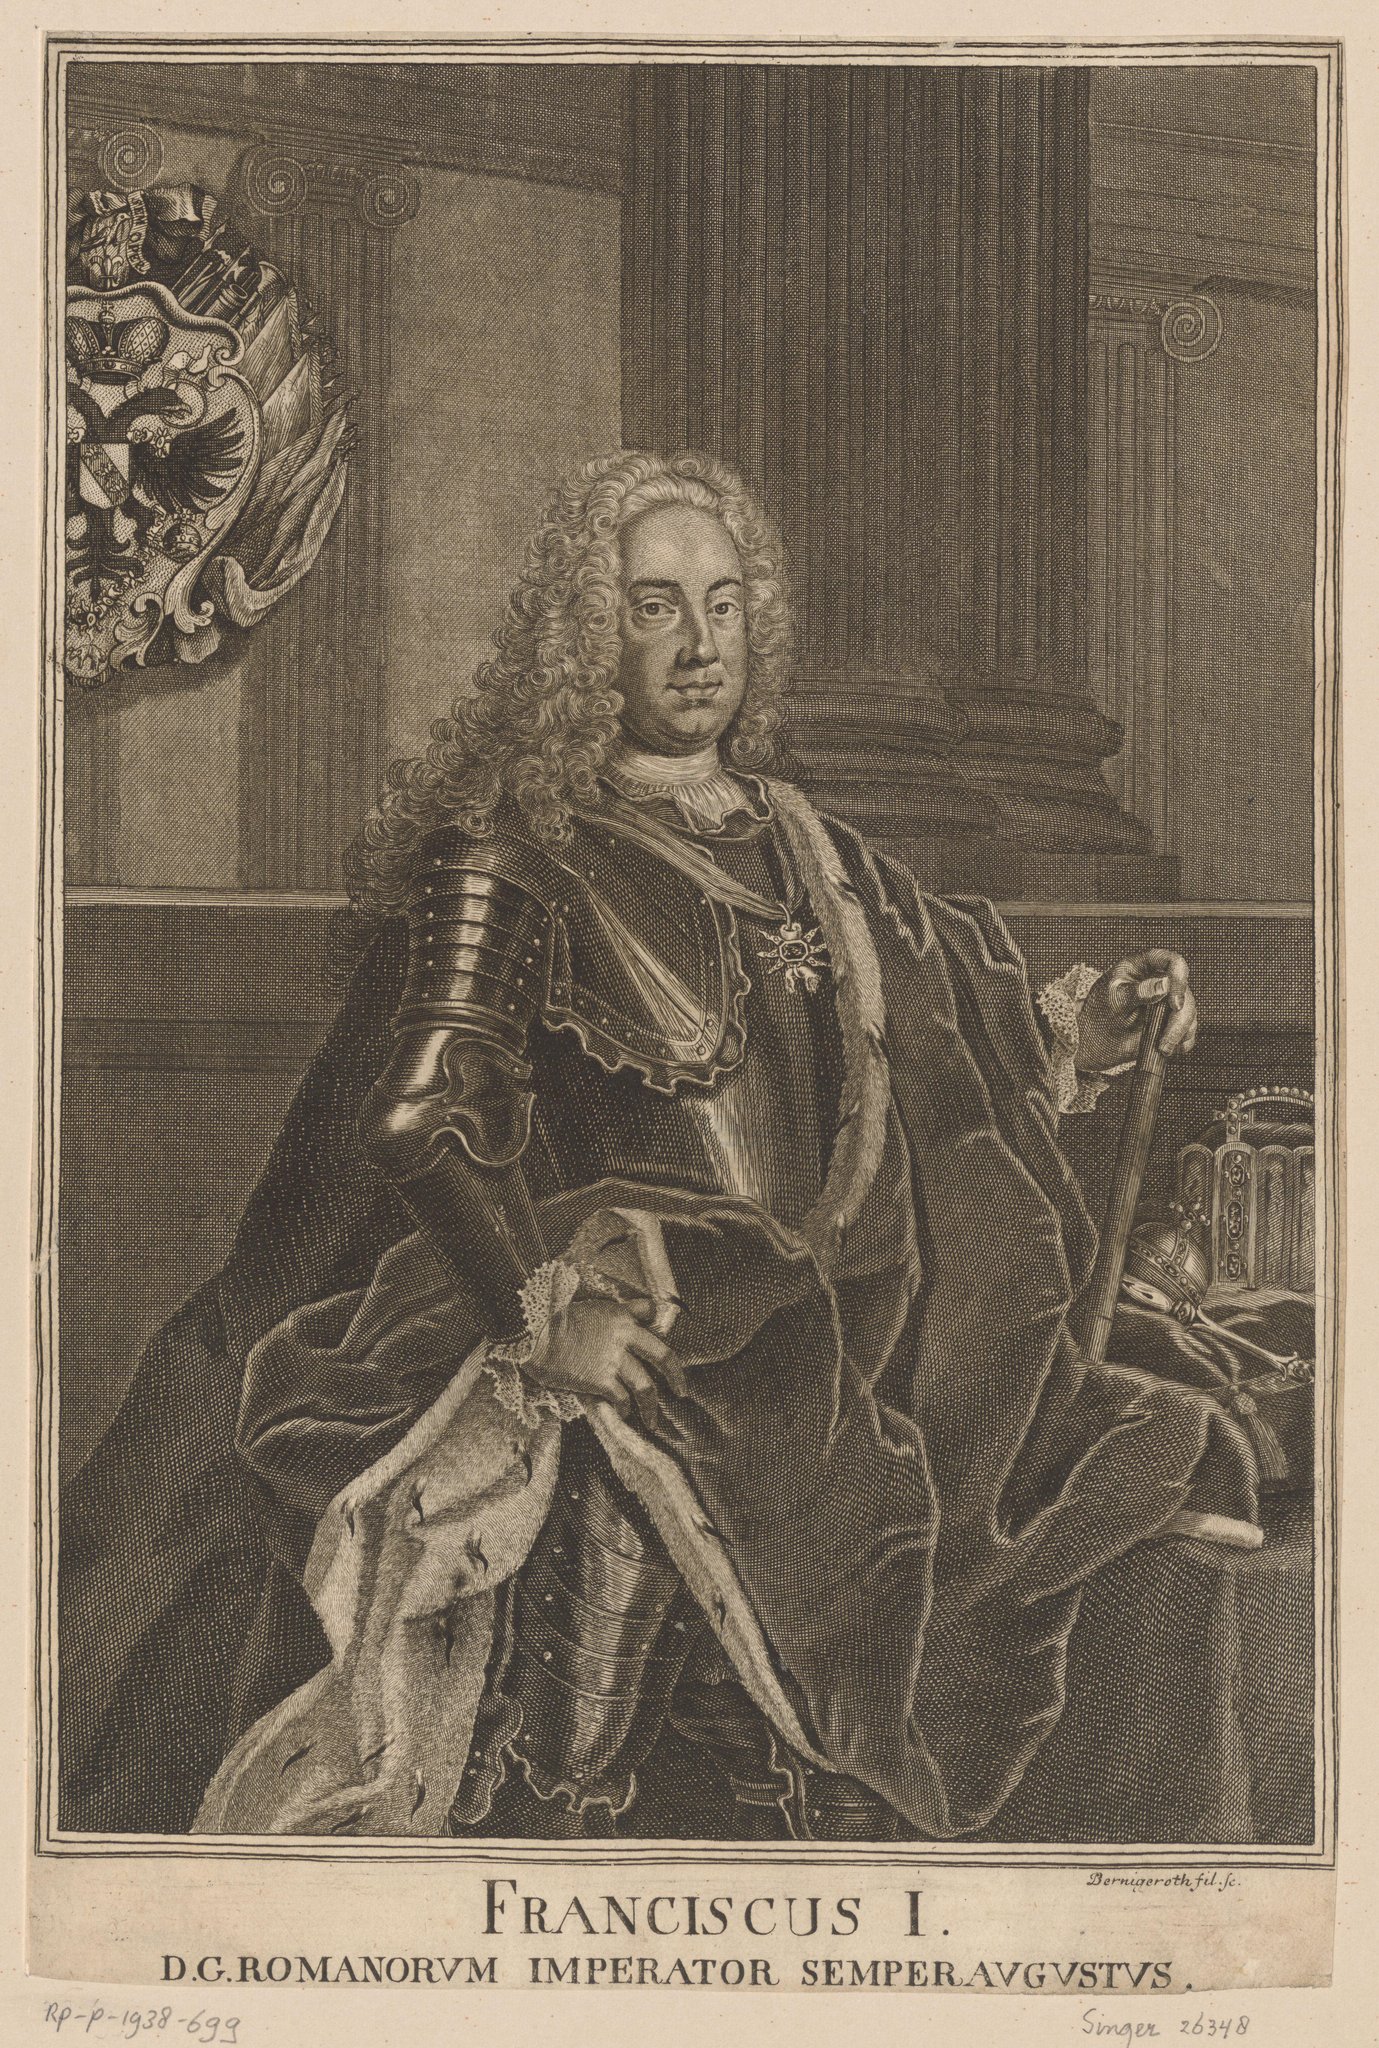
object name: print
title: Portret van keizer Frans I Stefan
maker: johann martin bernigeroth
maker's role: print maker, publisher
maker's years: 1713-1767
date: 1745-1767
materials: paper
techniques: engraving, etching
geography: leipzig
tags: frans i stefan (duits keizer), coat of arms (symbol of sovereignty), crown (symbol of sovereignty), orb (symbol of sovereignty; sphere with cross on top), armour, historical persons, knighthood order of the golden fleece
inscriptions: collector's mark: Lugt 2228